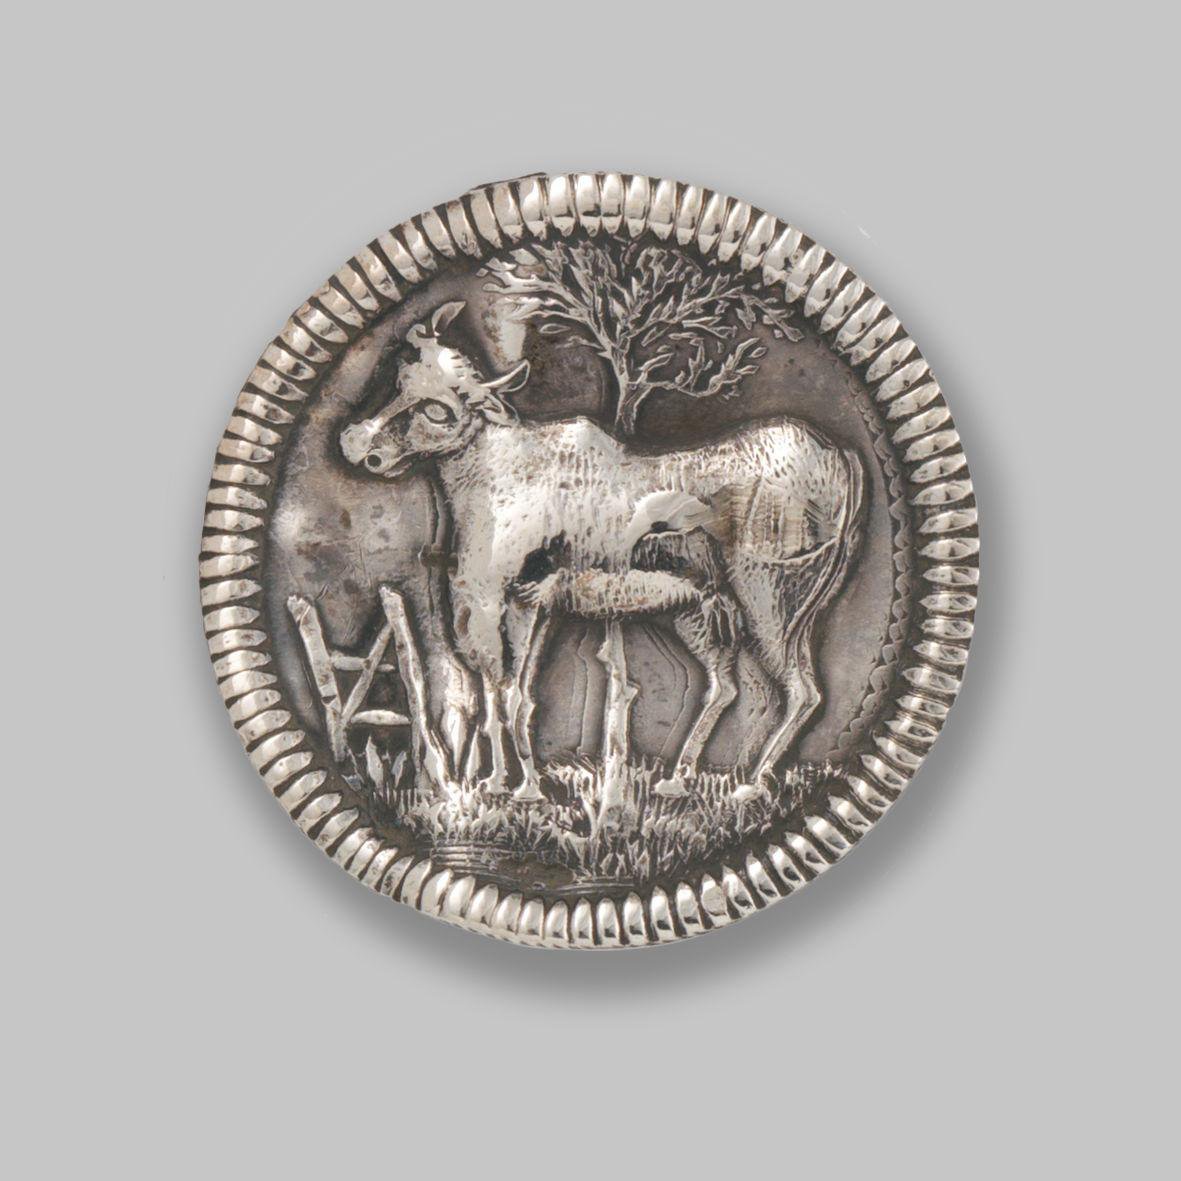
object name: button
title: Knoop met voorstelling van een koe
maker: Anonymous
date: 1850-1900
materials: silver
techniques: casting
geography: netherlands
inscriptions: alloy mark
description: Knoop van gegoten zilver, rond, met op de voorzijde een koe in een weiland omgeven door een geribde rand. Aan de achterzijde is een uit gebogen draad vervaardigd oog bevestigd.